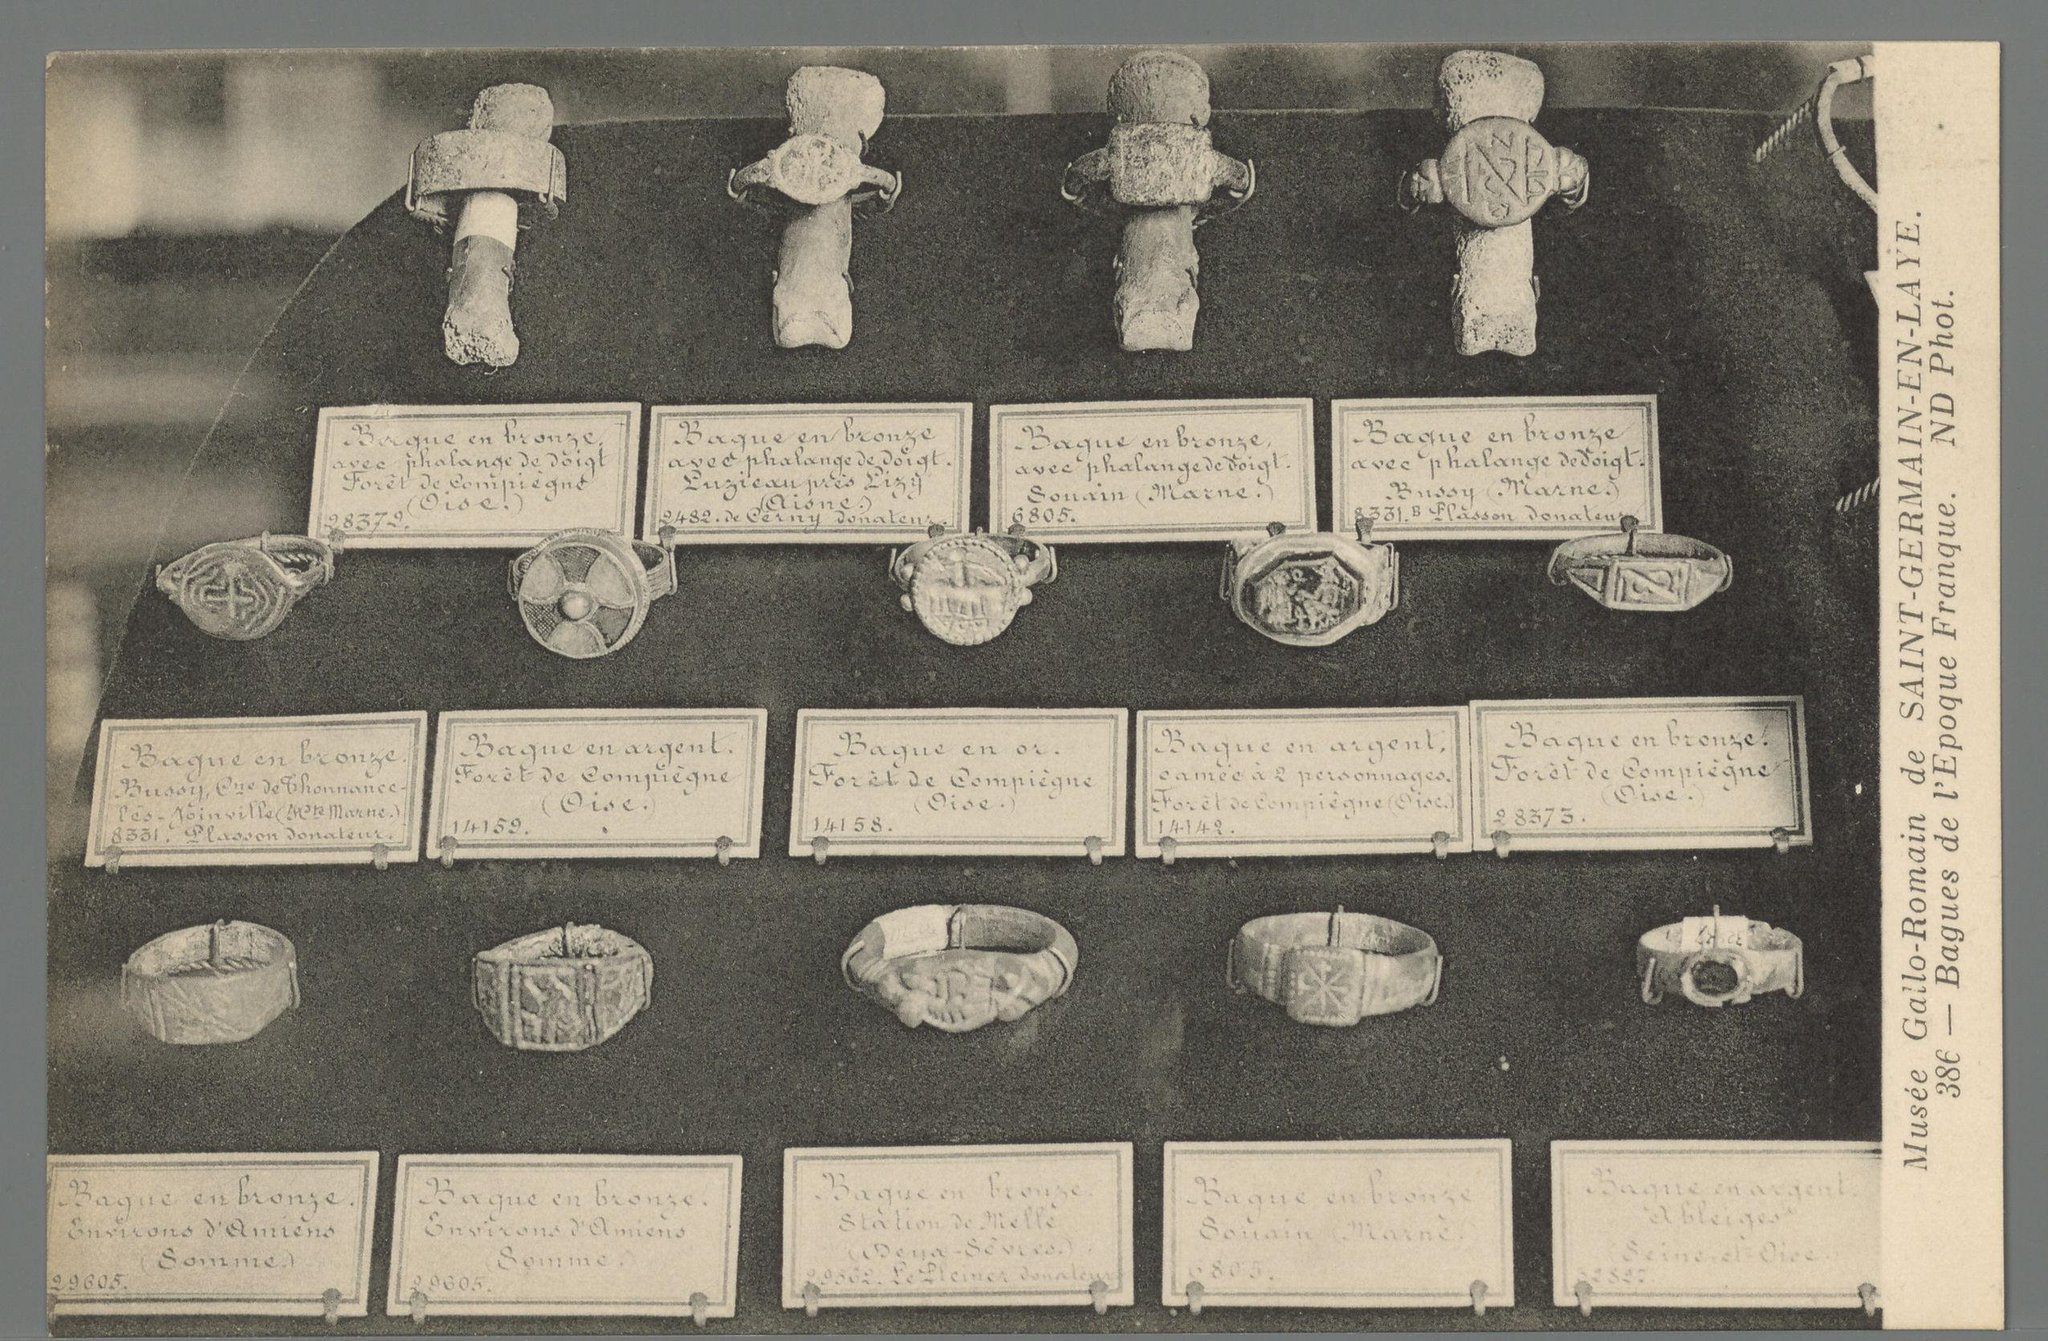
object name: photomechanical print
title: Musée Gallo-Romain de Saint-Germain-en-Laye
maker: Anonymous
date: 1903-1918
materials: cardboard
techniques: photograph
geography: saint-germain-en-laye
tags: permanent exhibition, museum, ring